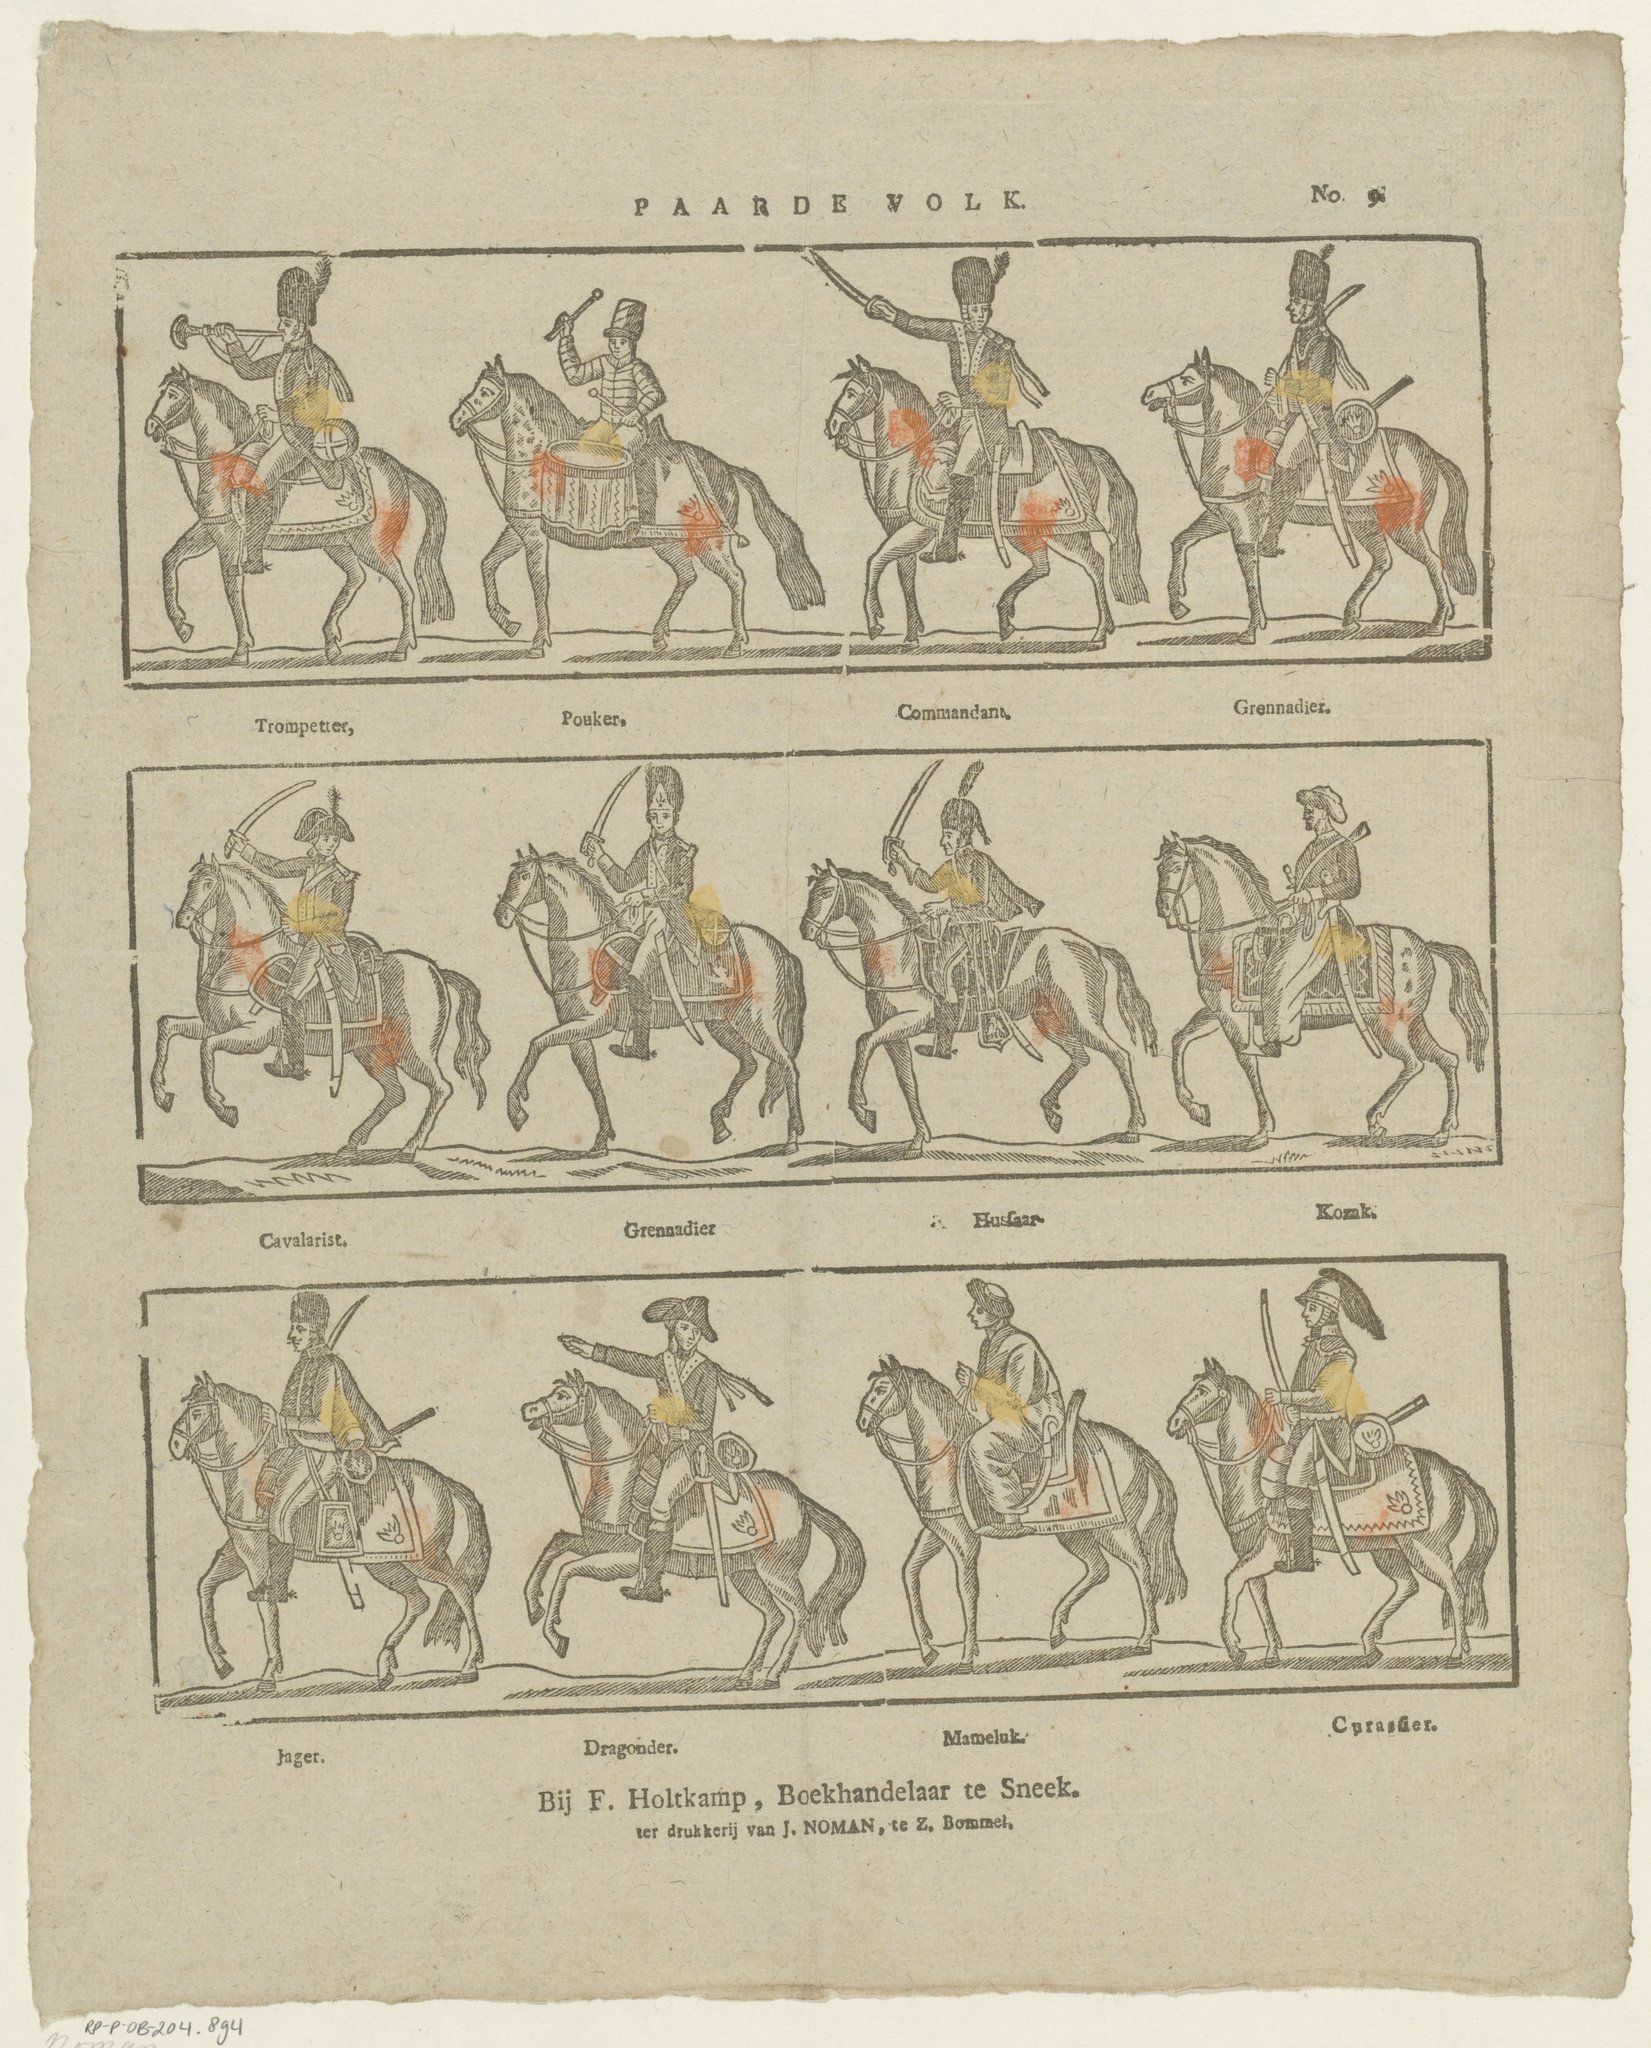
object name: popular print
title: Paarde volk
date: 1806-1830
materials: paper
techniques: colour, letterpress printing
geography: netherlands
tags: warfare; military affairs (+ cavalry, horsemen), the soldier; the soldier's life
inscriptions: collector's mark: Lugt 2760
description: Blad met 3 voorstellingen van telkens vier militairen te paard. Onder elke afbeelding een onderschrift. Genummerd rechtsboven: No. 9.